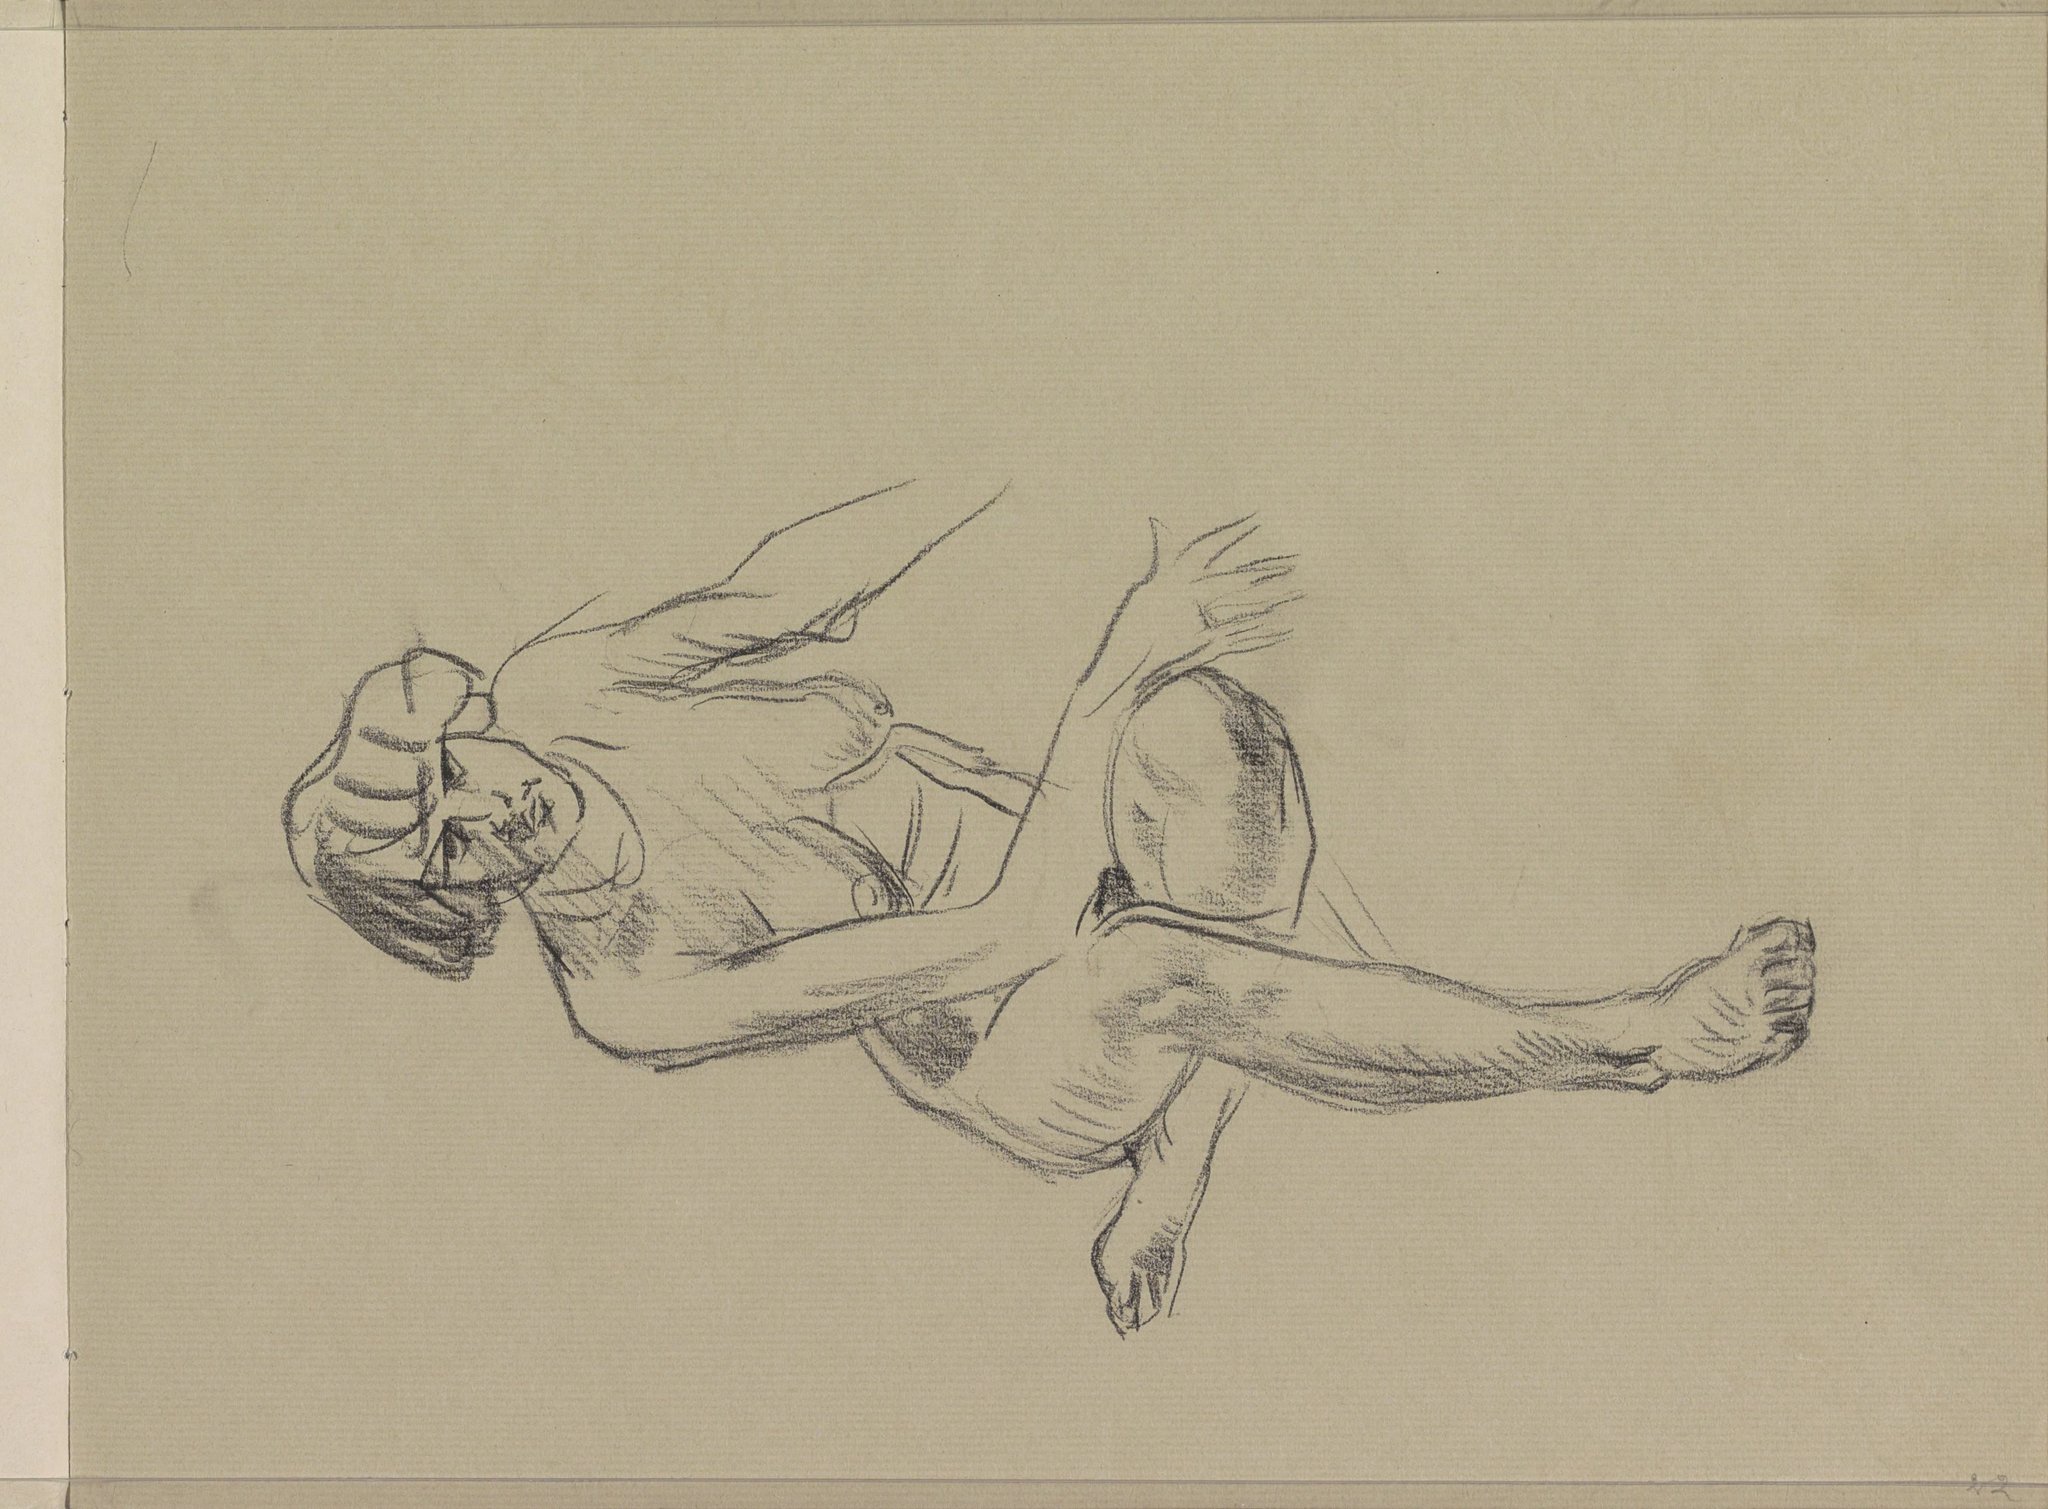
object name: sketchbook leaf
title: Seated Female Nude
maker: isaac israels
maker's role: draughtsman, painter, print maker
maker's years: 1865-1934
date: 1875-1934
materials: chalk, paper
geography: the hague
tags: sitting figure - aa - female human figure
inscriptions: watermark: ‘Holland’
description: Met een been opgetrokken. Blad 22 recto uit schetsboek IV met 27 bladen.